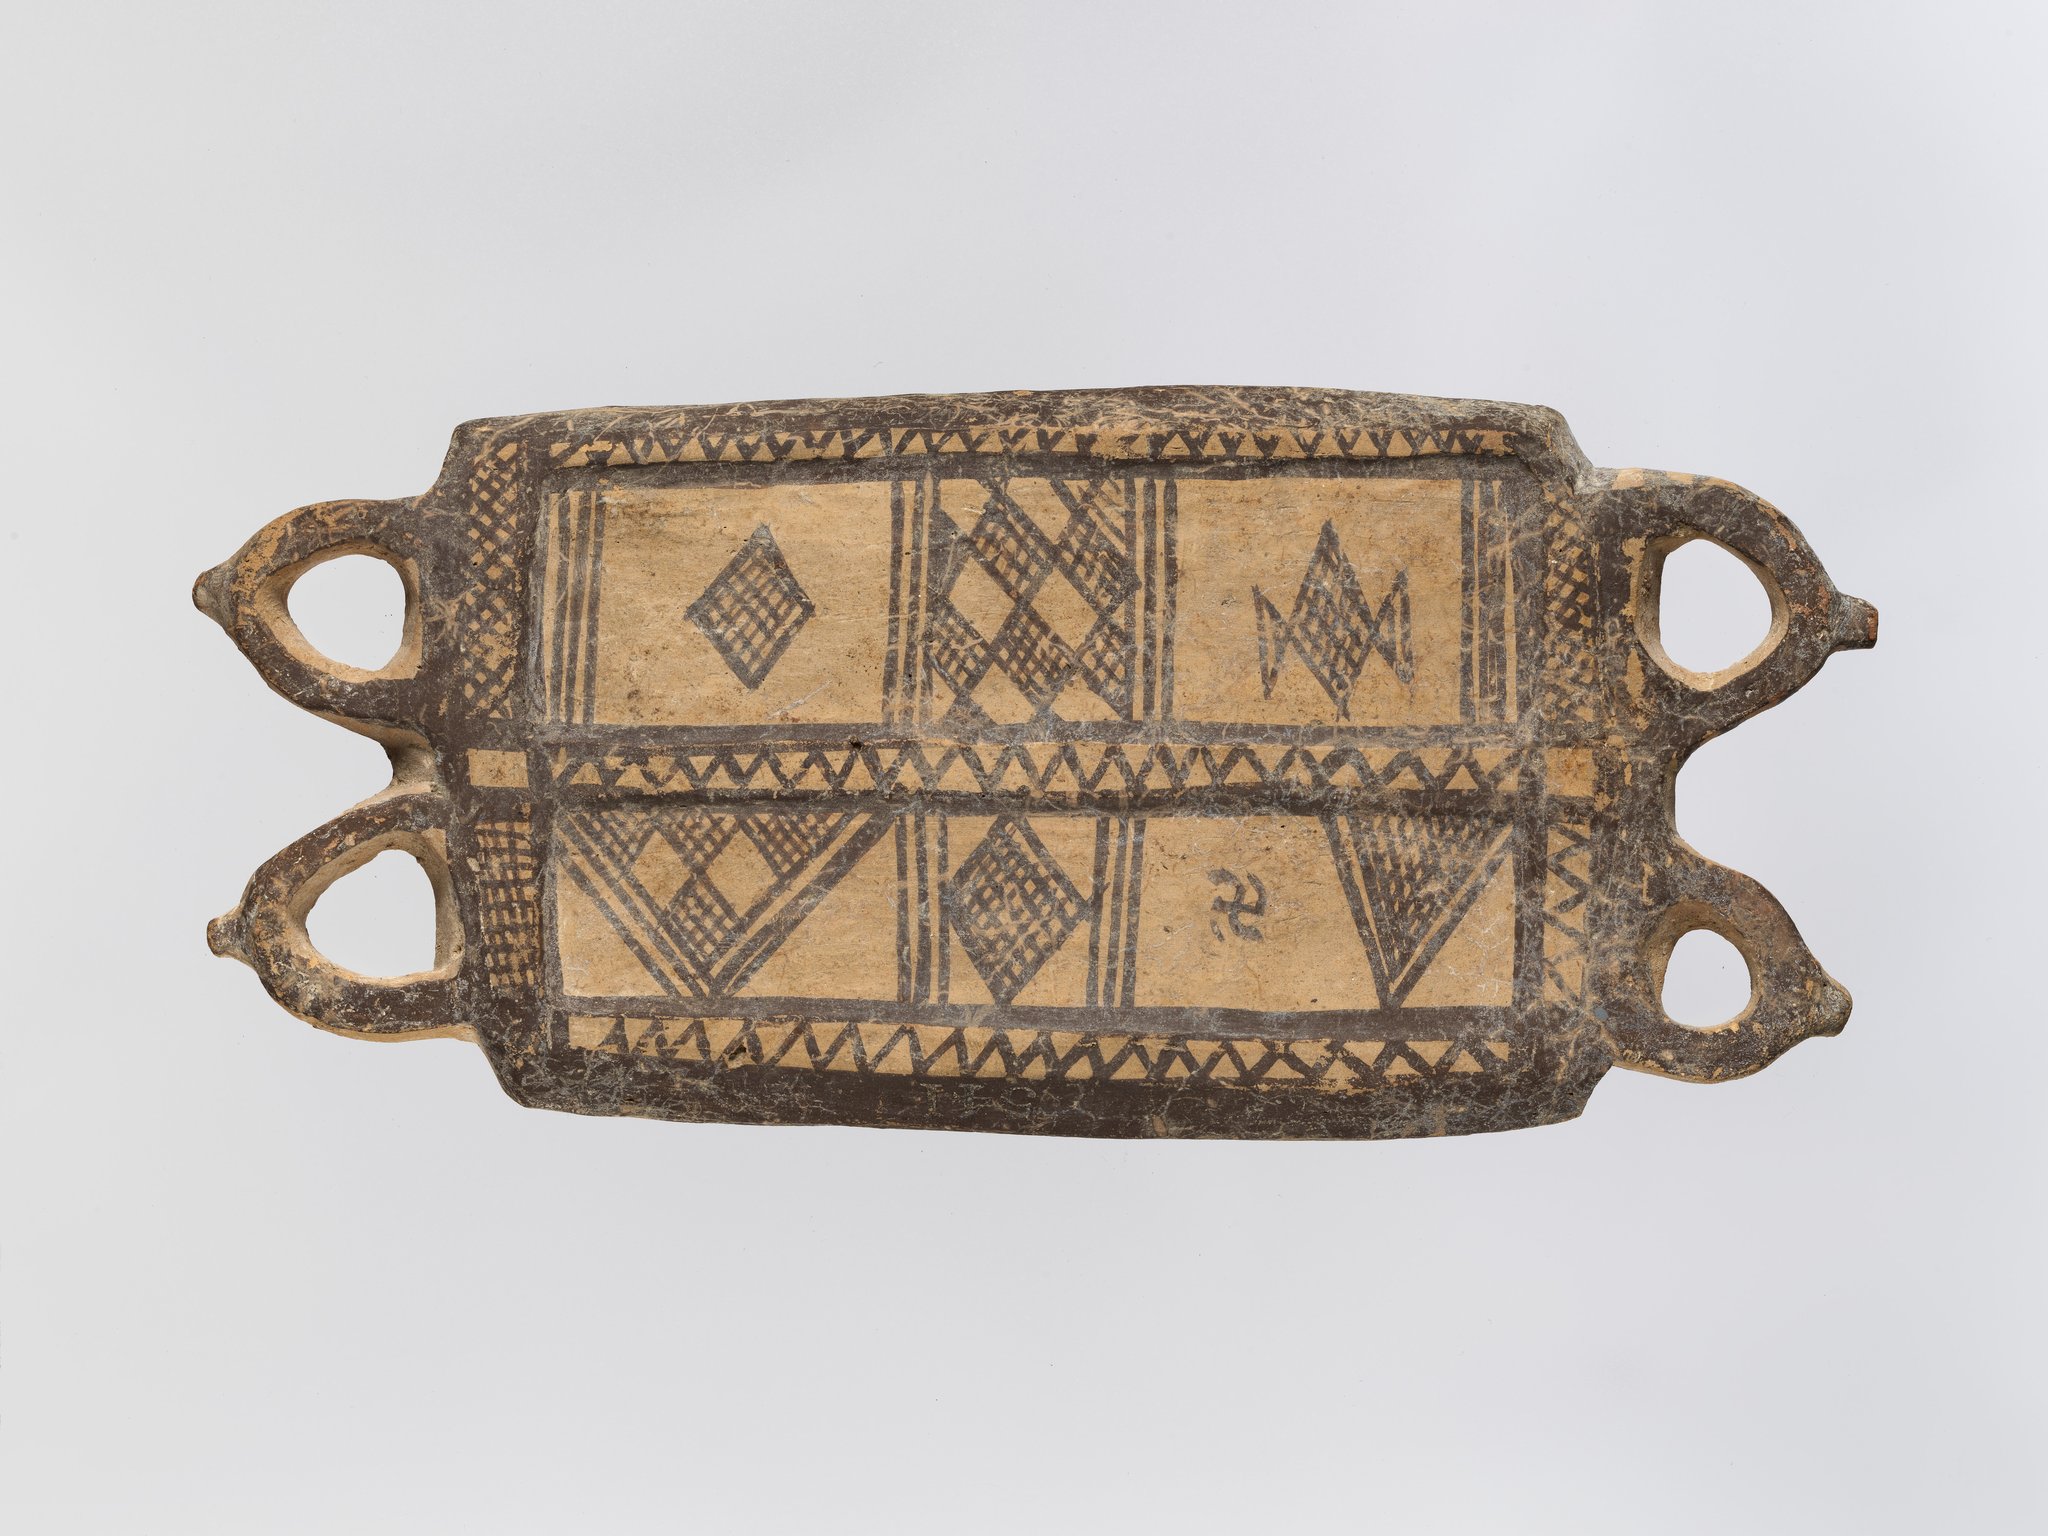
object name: tray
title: Terracotta tray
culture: cypriot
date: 1050-950 BCE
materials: terracotta